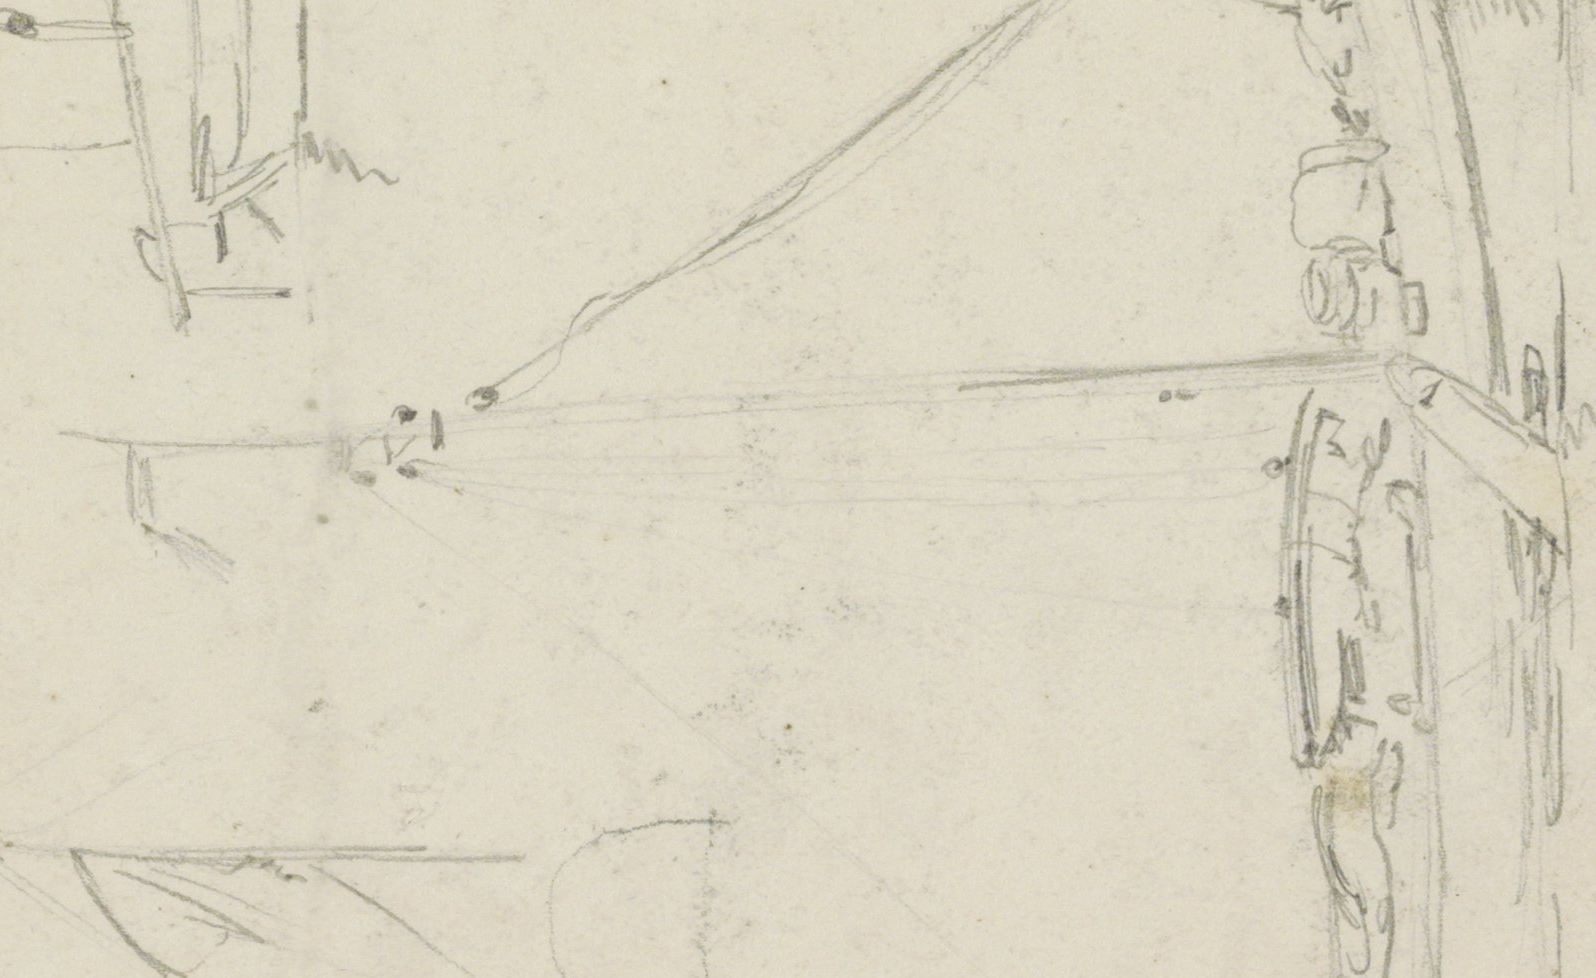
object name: sketchbook leaf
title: Studieblad met onderdelen van een zeilschip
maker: adrianus eversen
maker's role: draughtsman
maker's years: 1818-1897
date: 1828-1897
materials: paper, pencil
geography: netherlands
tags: sailing-ship, sailing-boat, parts of ship's exterior: mast, parts of ship's exterior: rudder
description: In het midden een zeilschip. In de boot liggen goederen. Links een mast met een vlag en rechts een studie van een achtersteven met het roer. Blad 1 recto uit een schetsboek met 27 bladen.